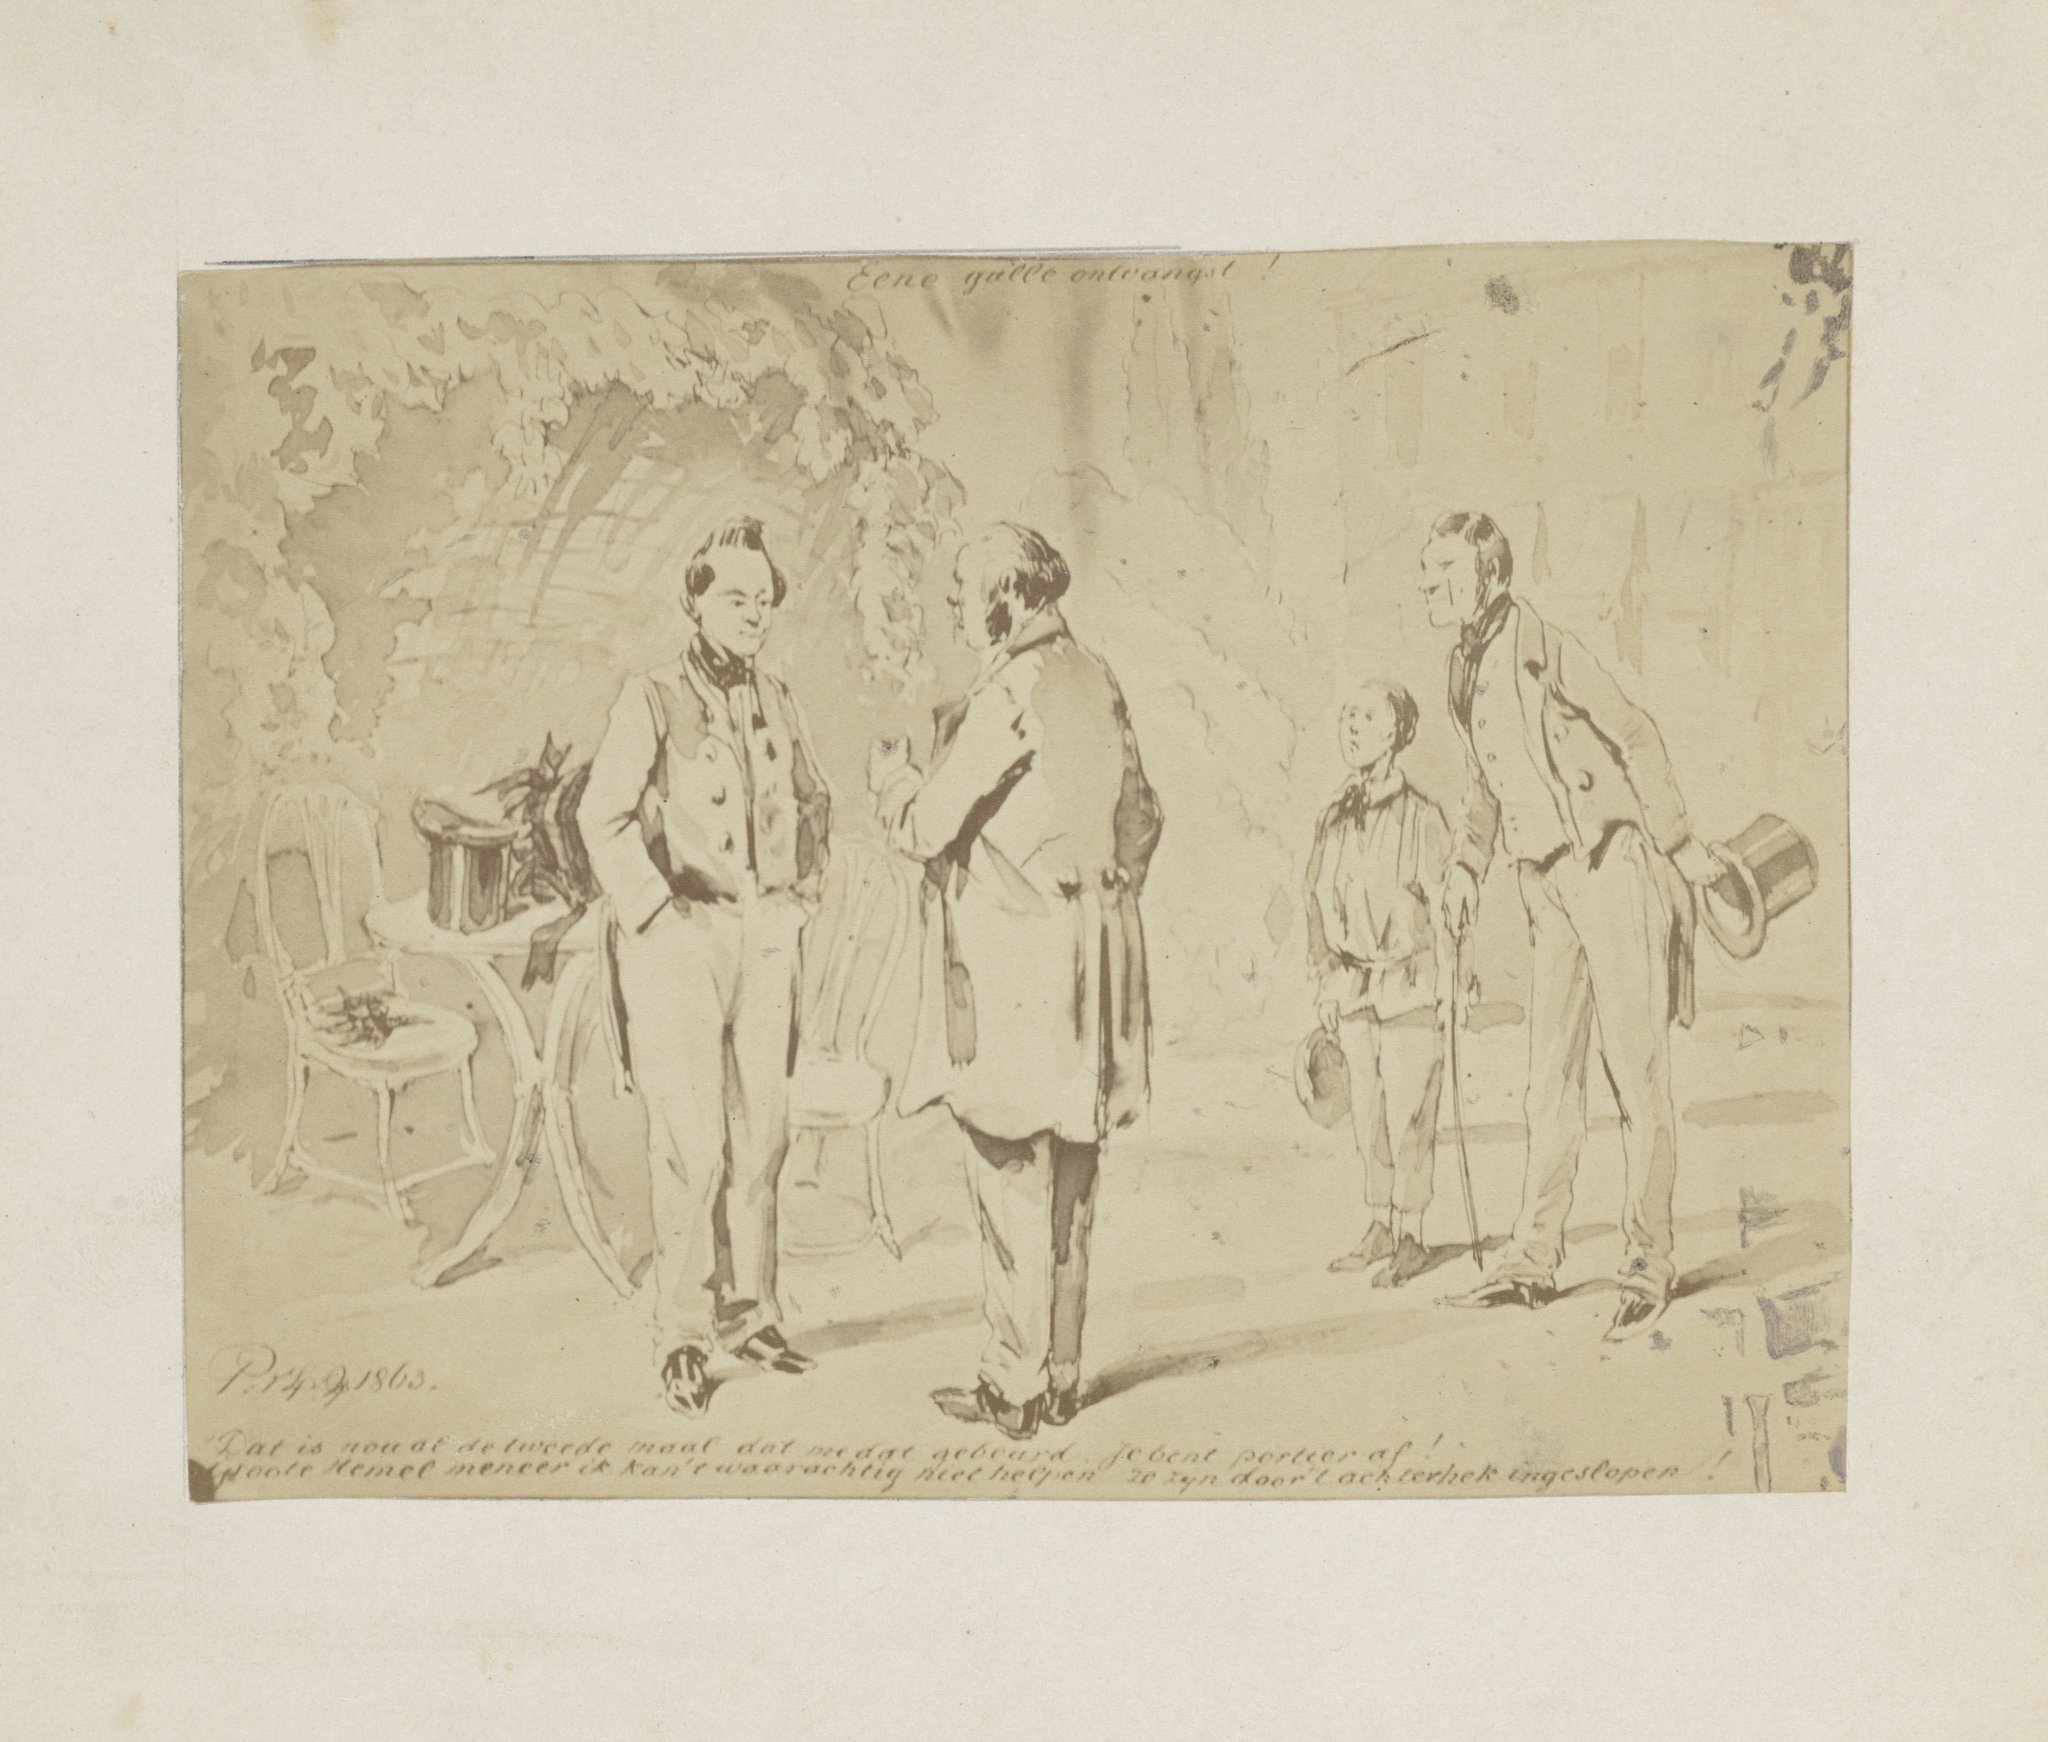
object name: photograph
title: Fotoreproductie van een tekening van jhr. Pieter van Loon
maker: Anonymous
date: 1863-1873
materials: cardboard, paper, photographic support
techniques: albumen print